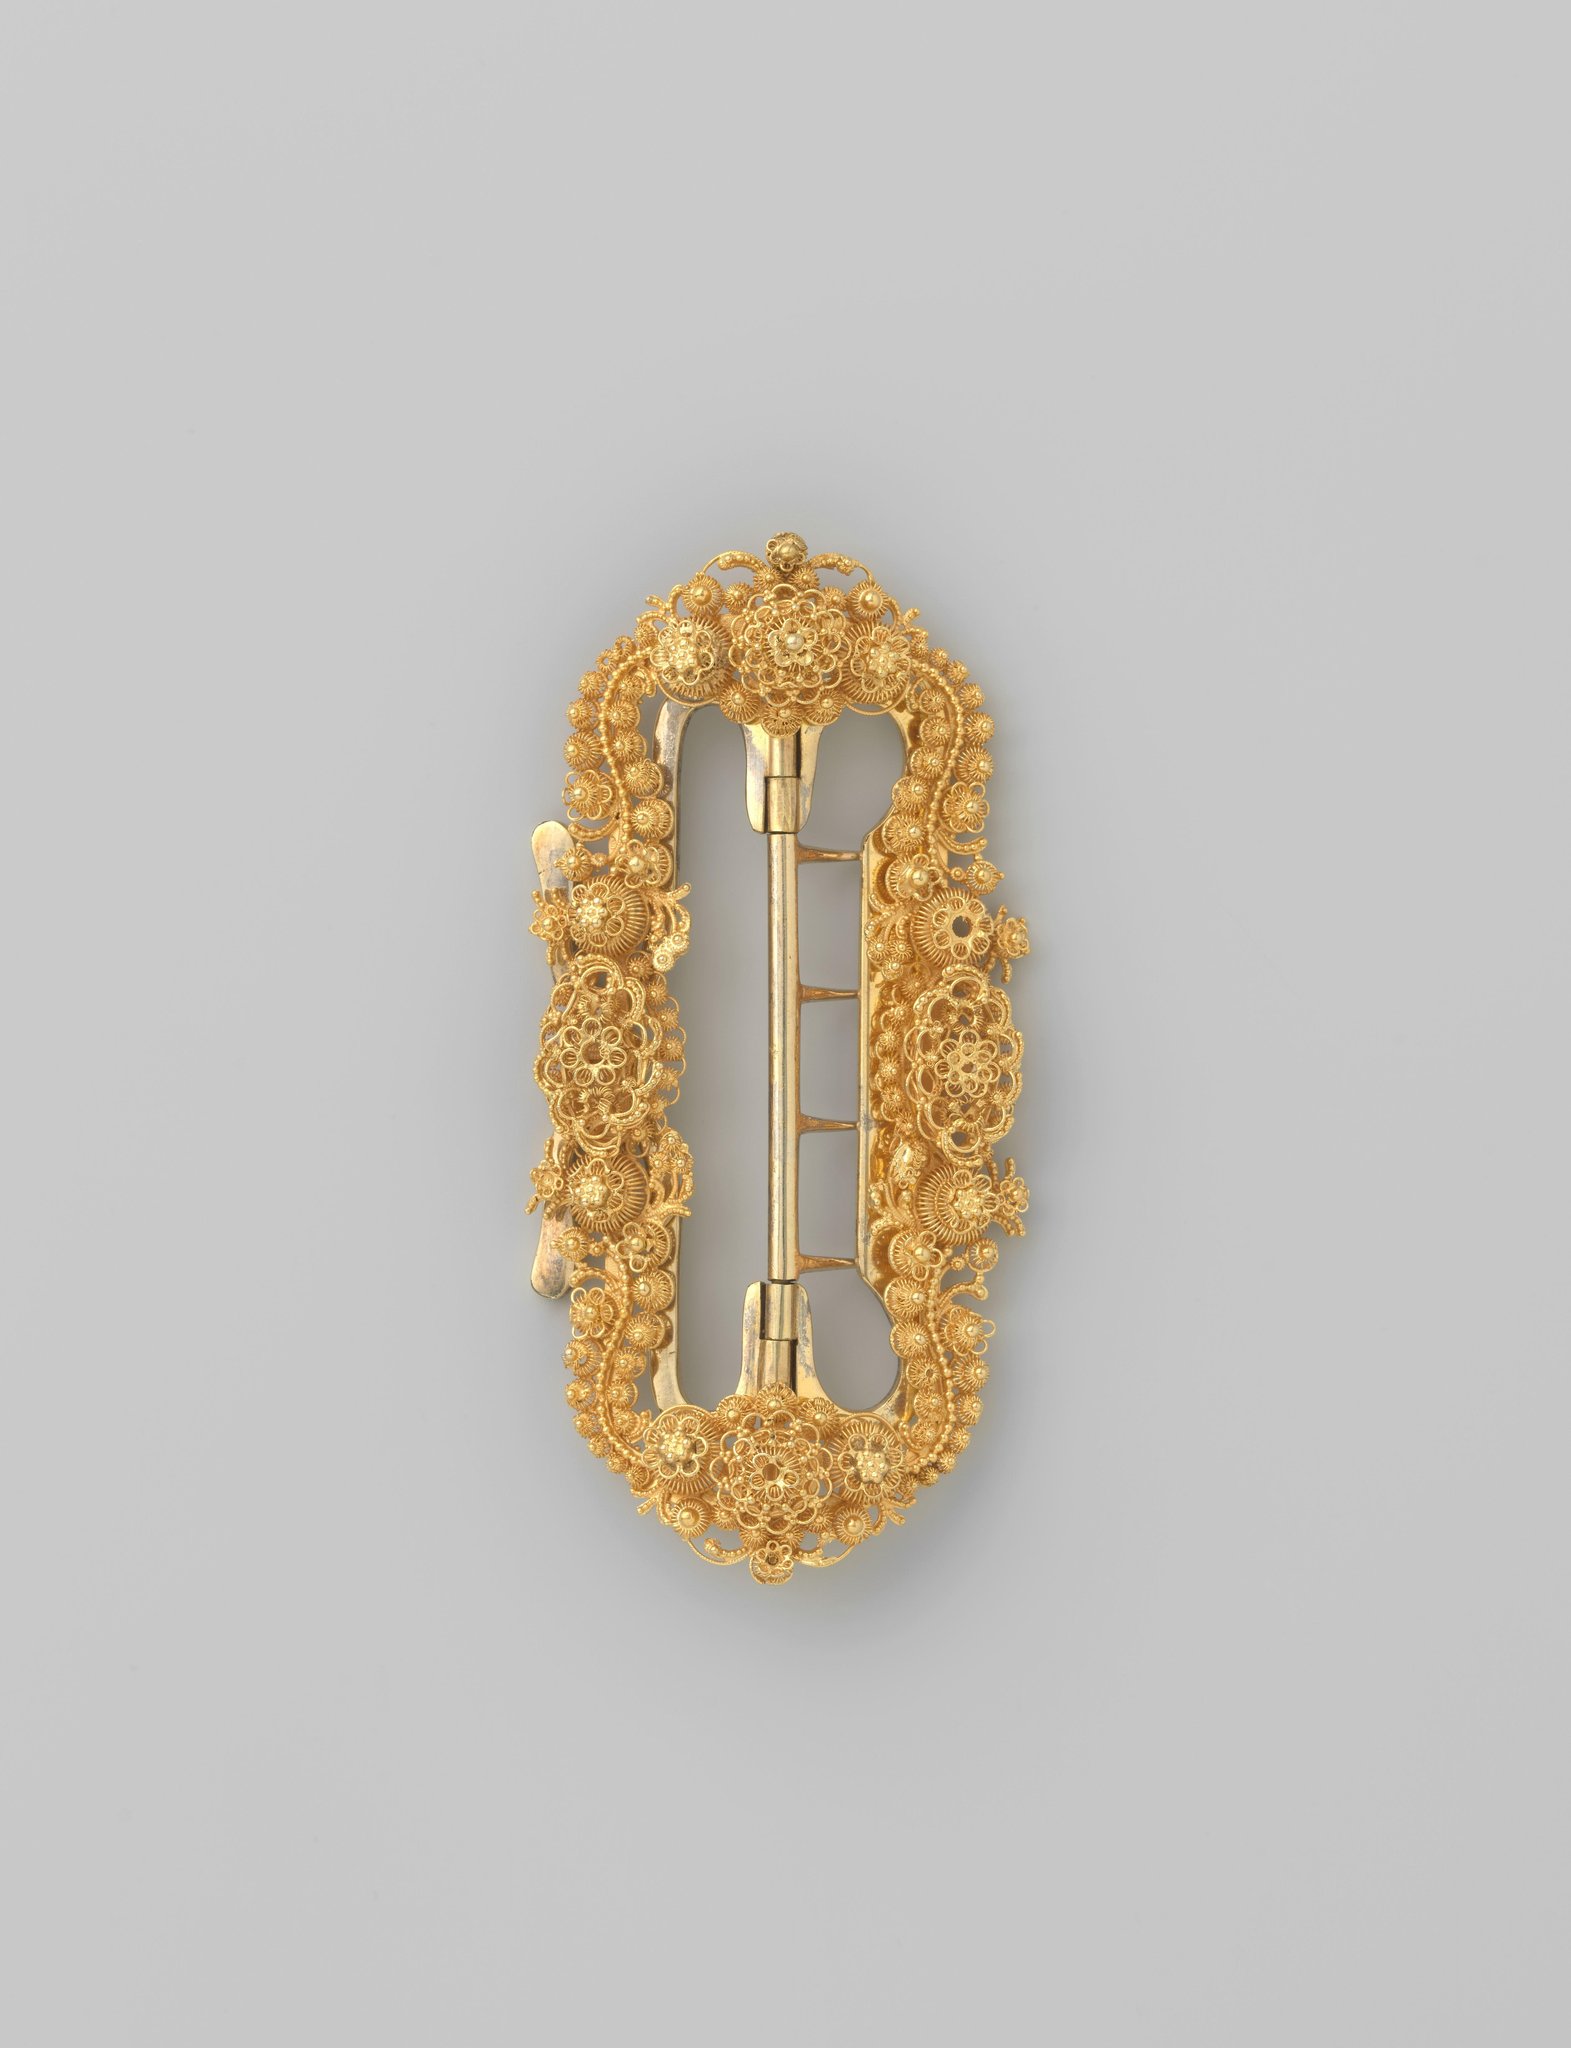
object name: ceintuurgesp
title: Ceintuurgesp van cantillewerk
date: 1824-1830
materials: gold, silver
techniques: gilding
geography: amsterdam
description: Ceintuurgesp versierd met cantillewerk in goud. Door met dun gouddraad driedimensionale vormen te creëren wordt de suggestie van een volumineus juweel gewekt. Deze stijl, geïnspireerd door borduurwerk, was geliefd in de periode 1820-1840. Cantillewerk is fragiel en een aantal van de zogenaamde 'spinnetjes' zijn verloren gegaan.